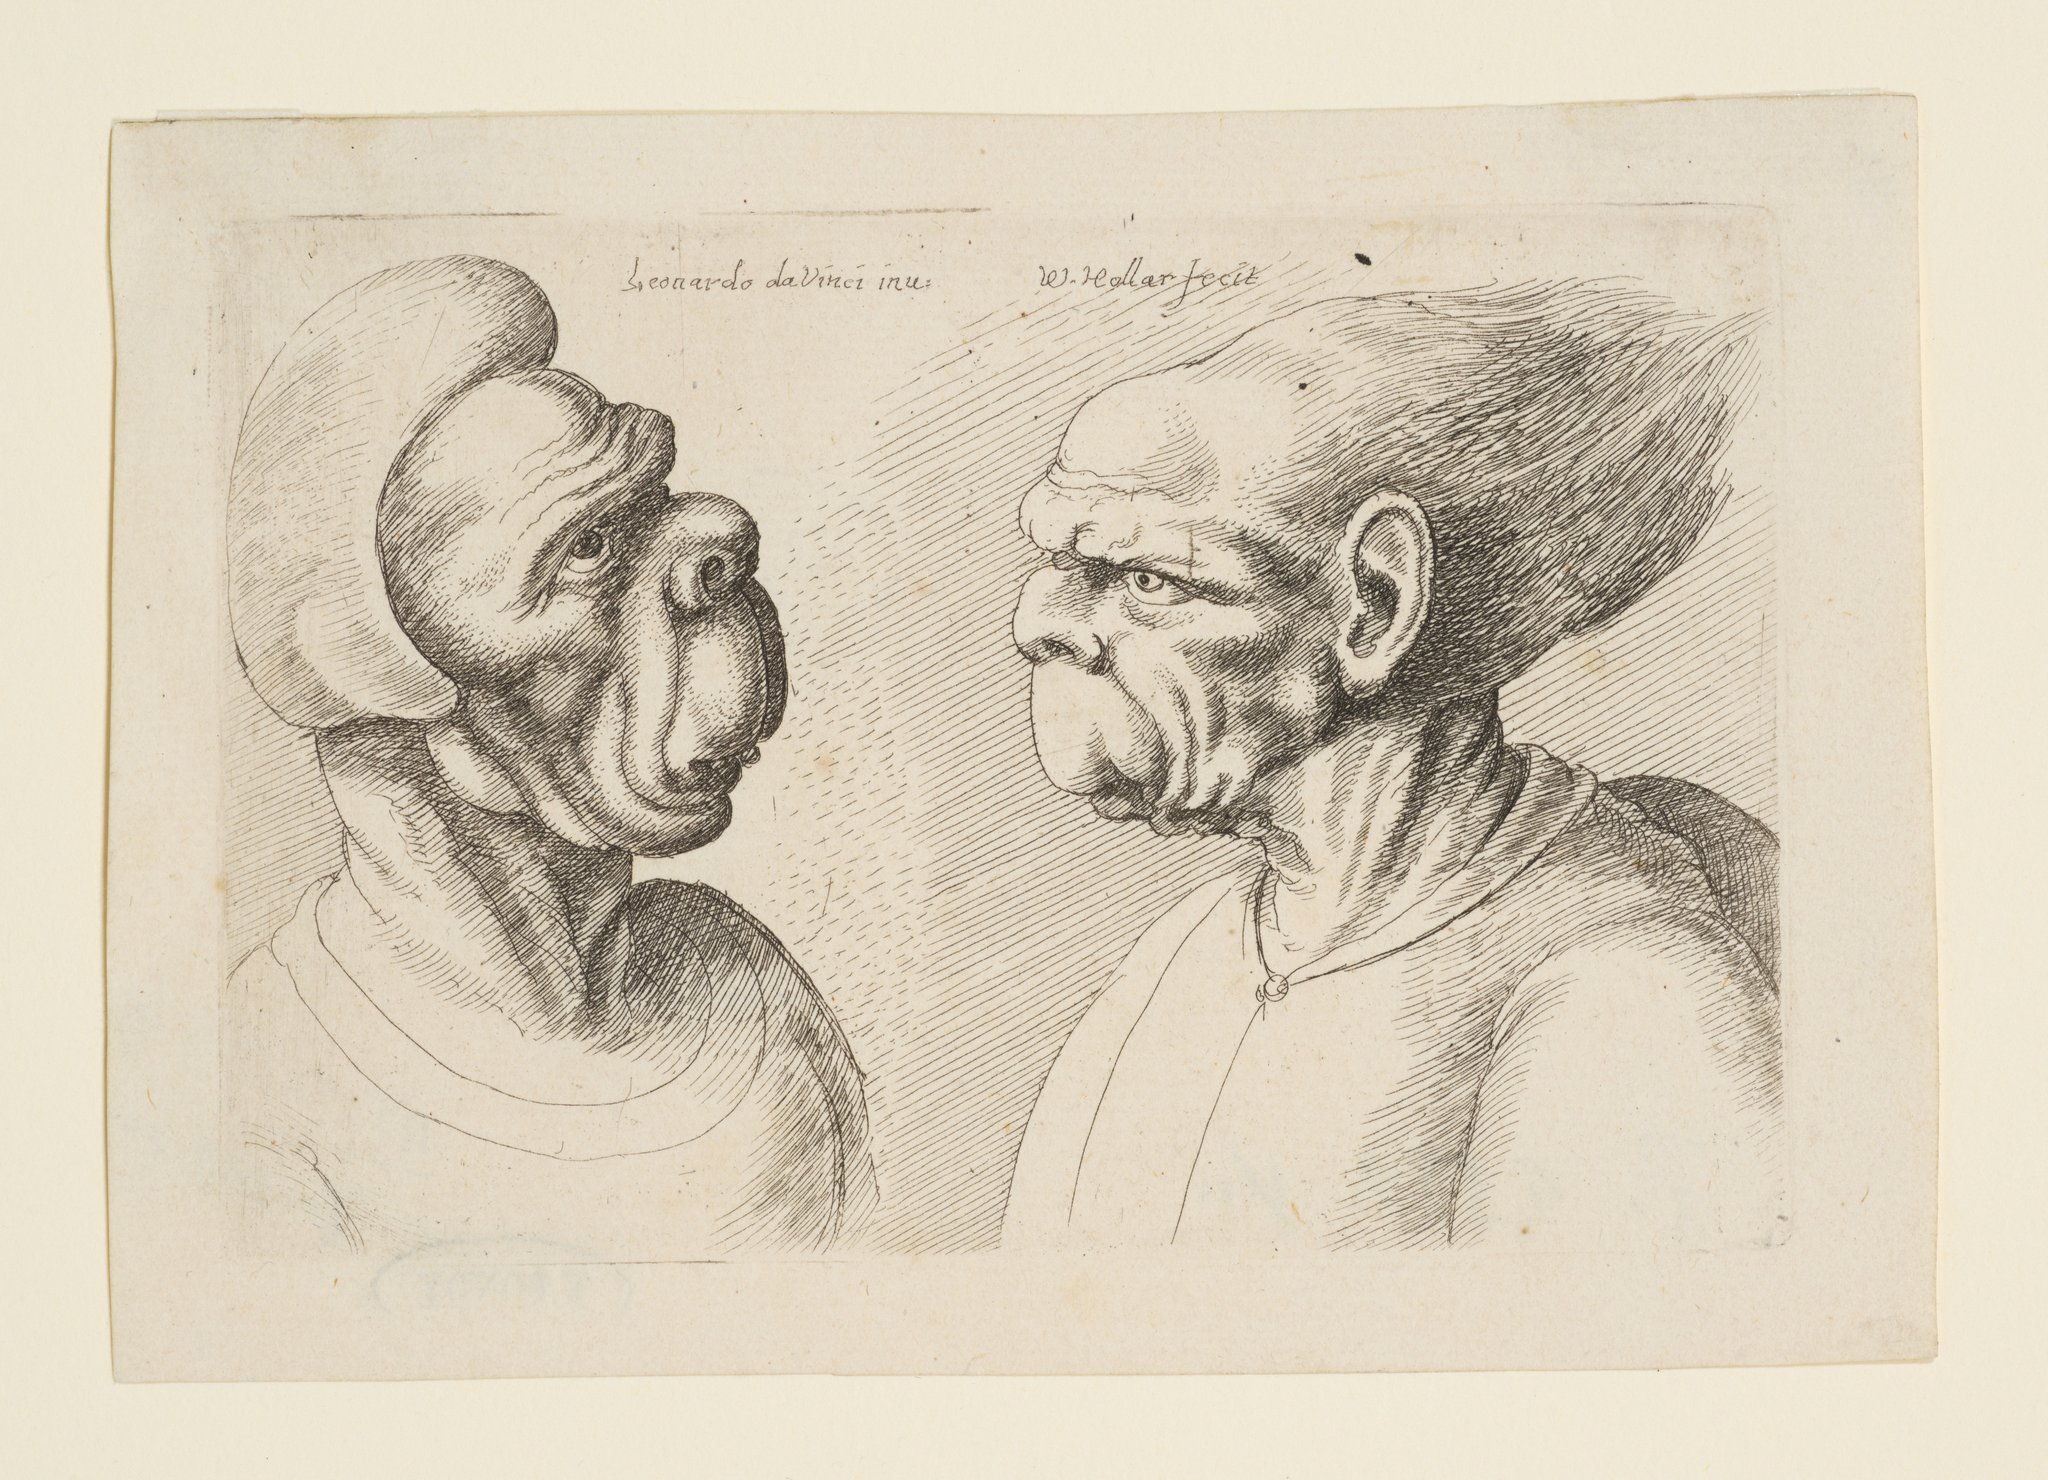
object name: print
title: Two Deformed Heads with Very Long Upper Lips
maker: wenceslaus hollar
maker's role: artist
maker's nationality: bohemian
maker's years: 1607-1677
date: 1645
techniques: etching